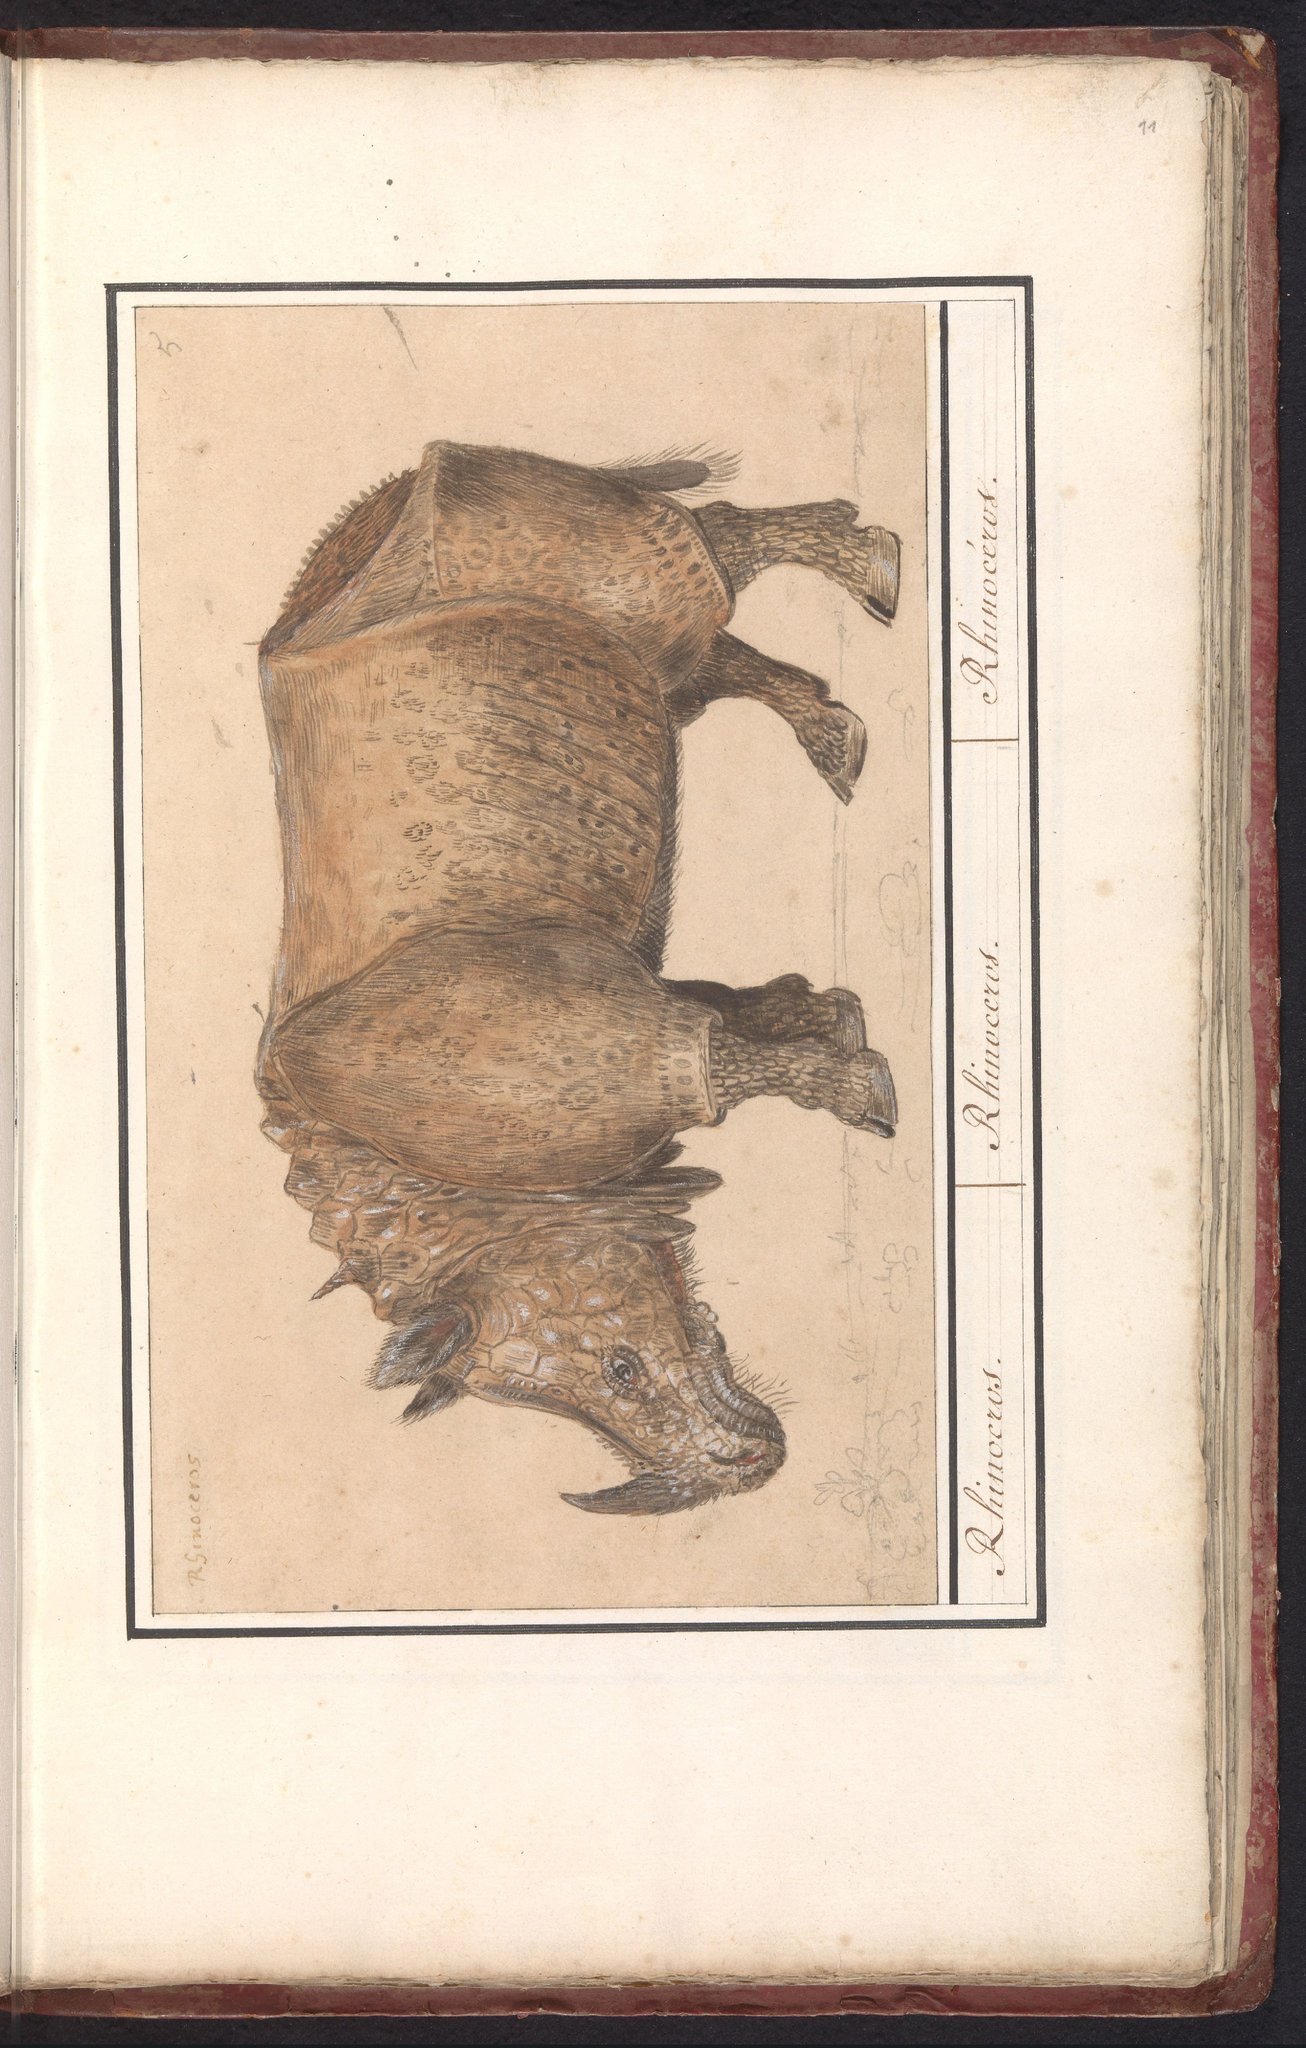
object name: drawing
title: Rhinoceros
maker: anselmus boëtius de boodt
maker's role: draughtsman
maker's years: 1550-1632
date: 1596-1610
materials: paint, paper, pencil, watercolor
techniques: brush, pen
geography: prague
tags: hoofed animals: rhinoceros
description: Around 1600 Anselmus de Boodt compiles several albums for Emperor Rudolf II in which he depicts animals from the imperial menagerie in Prague. While a rhinoceros is missing from this zoo, it nevertheless belongs in these albums which collectively reflect the animal kingdom as it was known at that time. Naturally, De Boodt relies on the image that Dürer had made almost a century earlier.